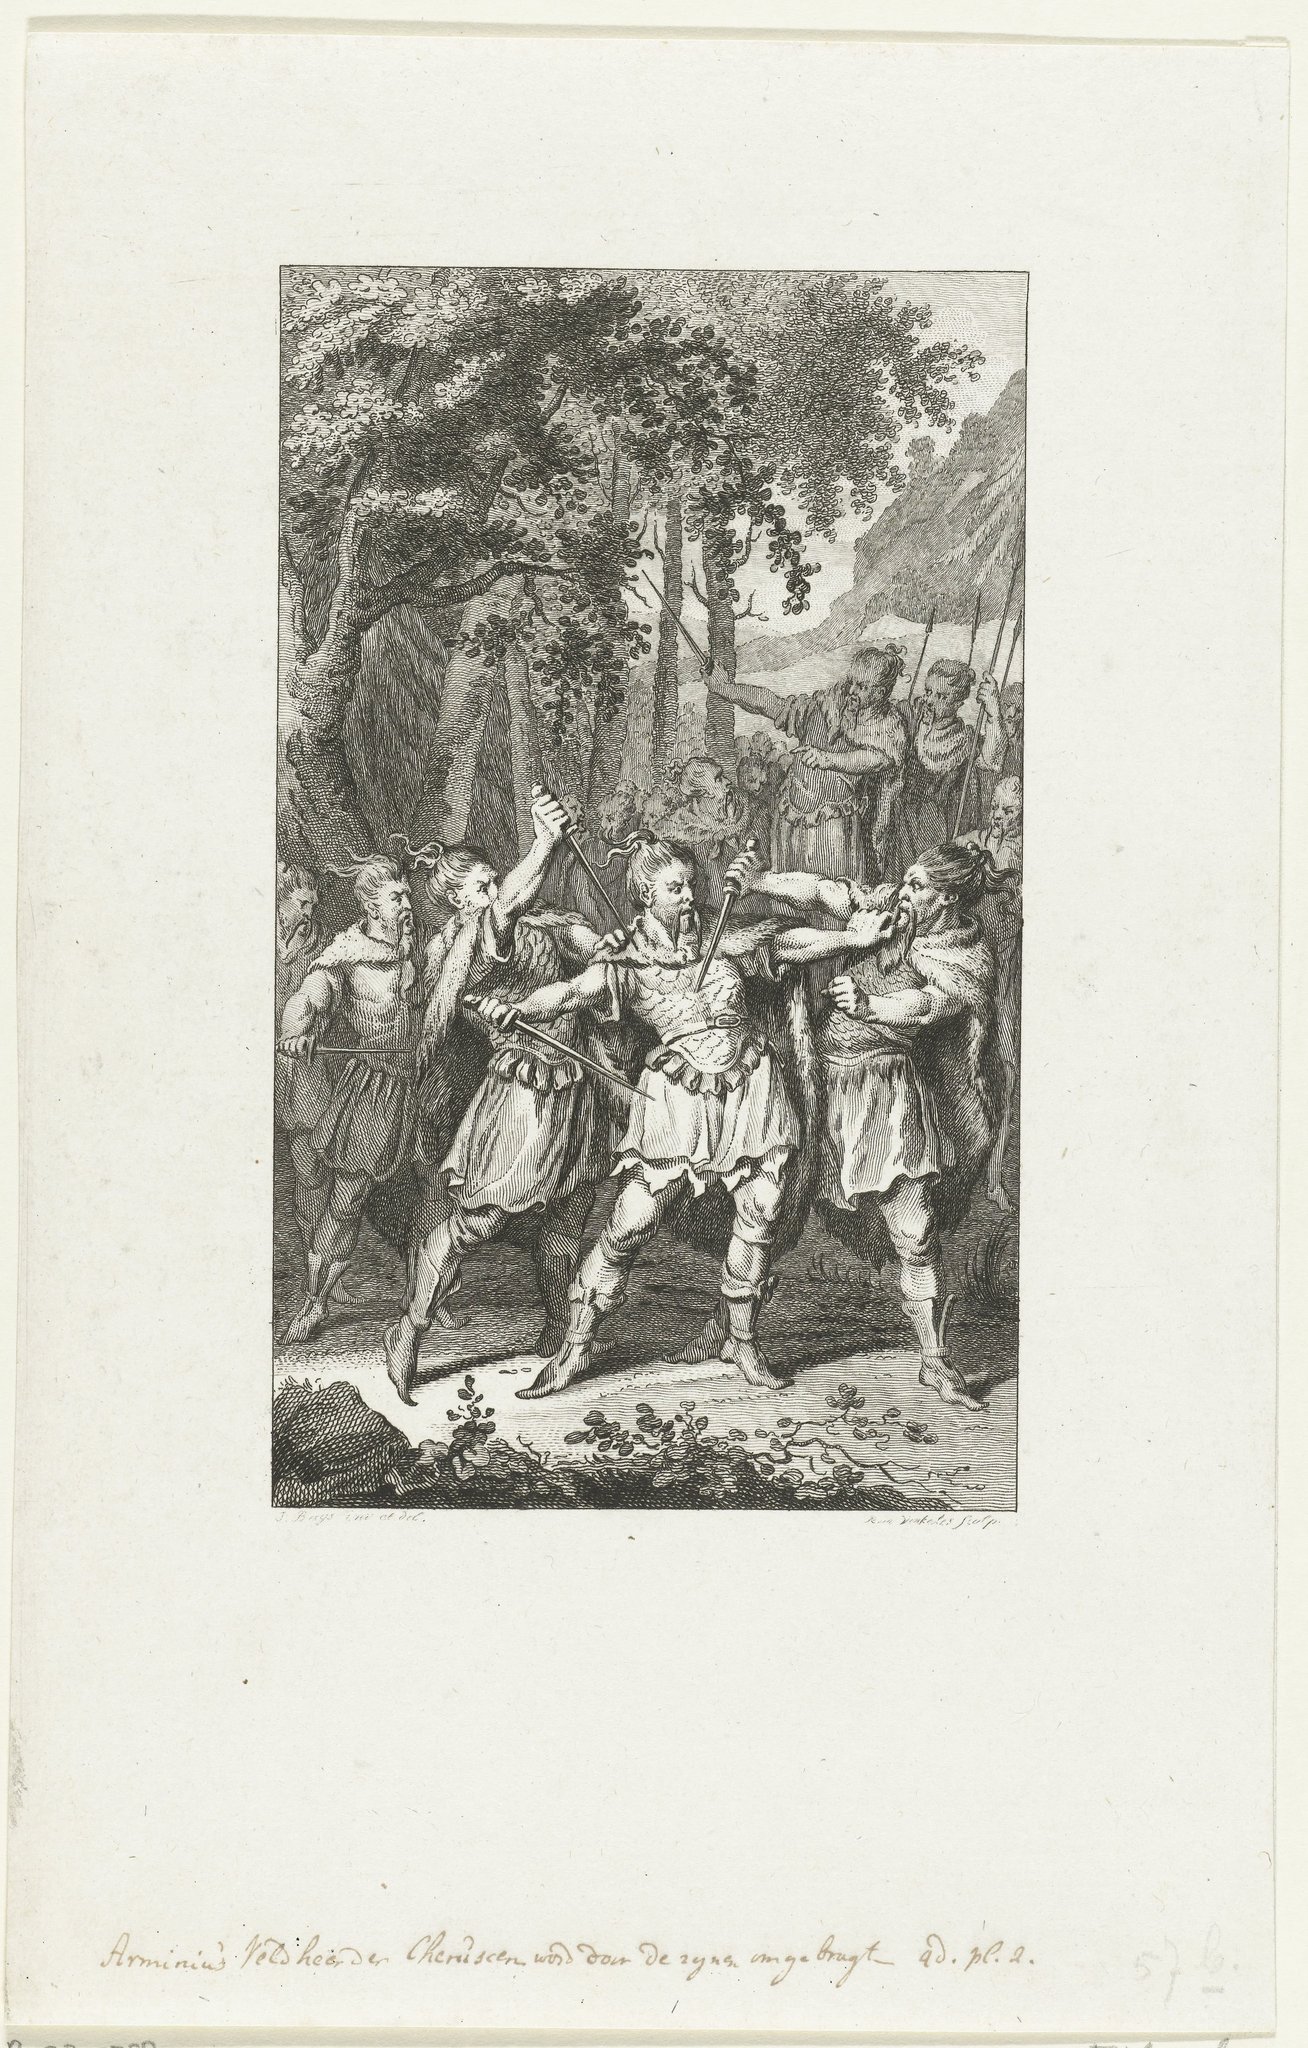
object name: history print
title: Moord op de Germaanse veldheer Arminius, 19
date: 1786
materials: paper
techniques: etching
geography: netherlands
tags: extinct, 'historical' peoples (with name), attempt, political murder, netherlands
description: De Germaanse veldheer Arminius, leider van de stam der Cherusken, wordt in 19 (volgens FM in het jaar 17) door leden van zijn eigen stam vermoord.